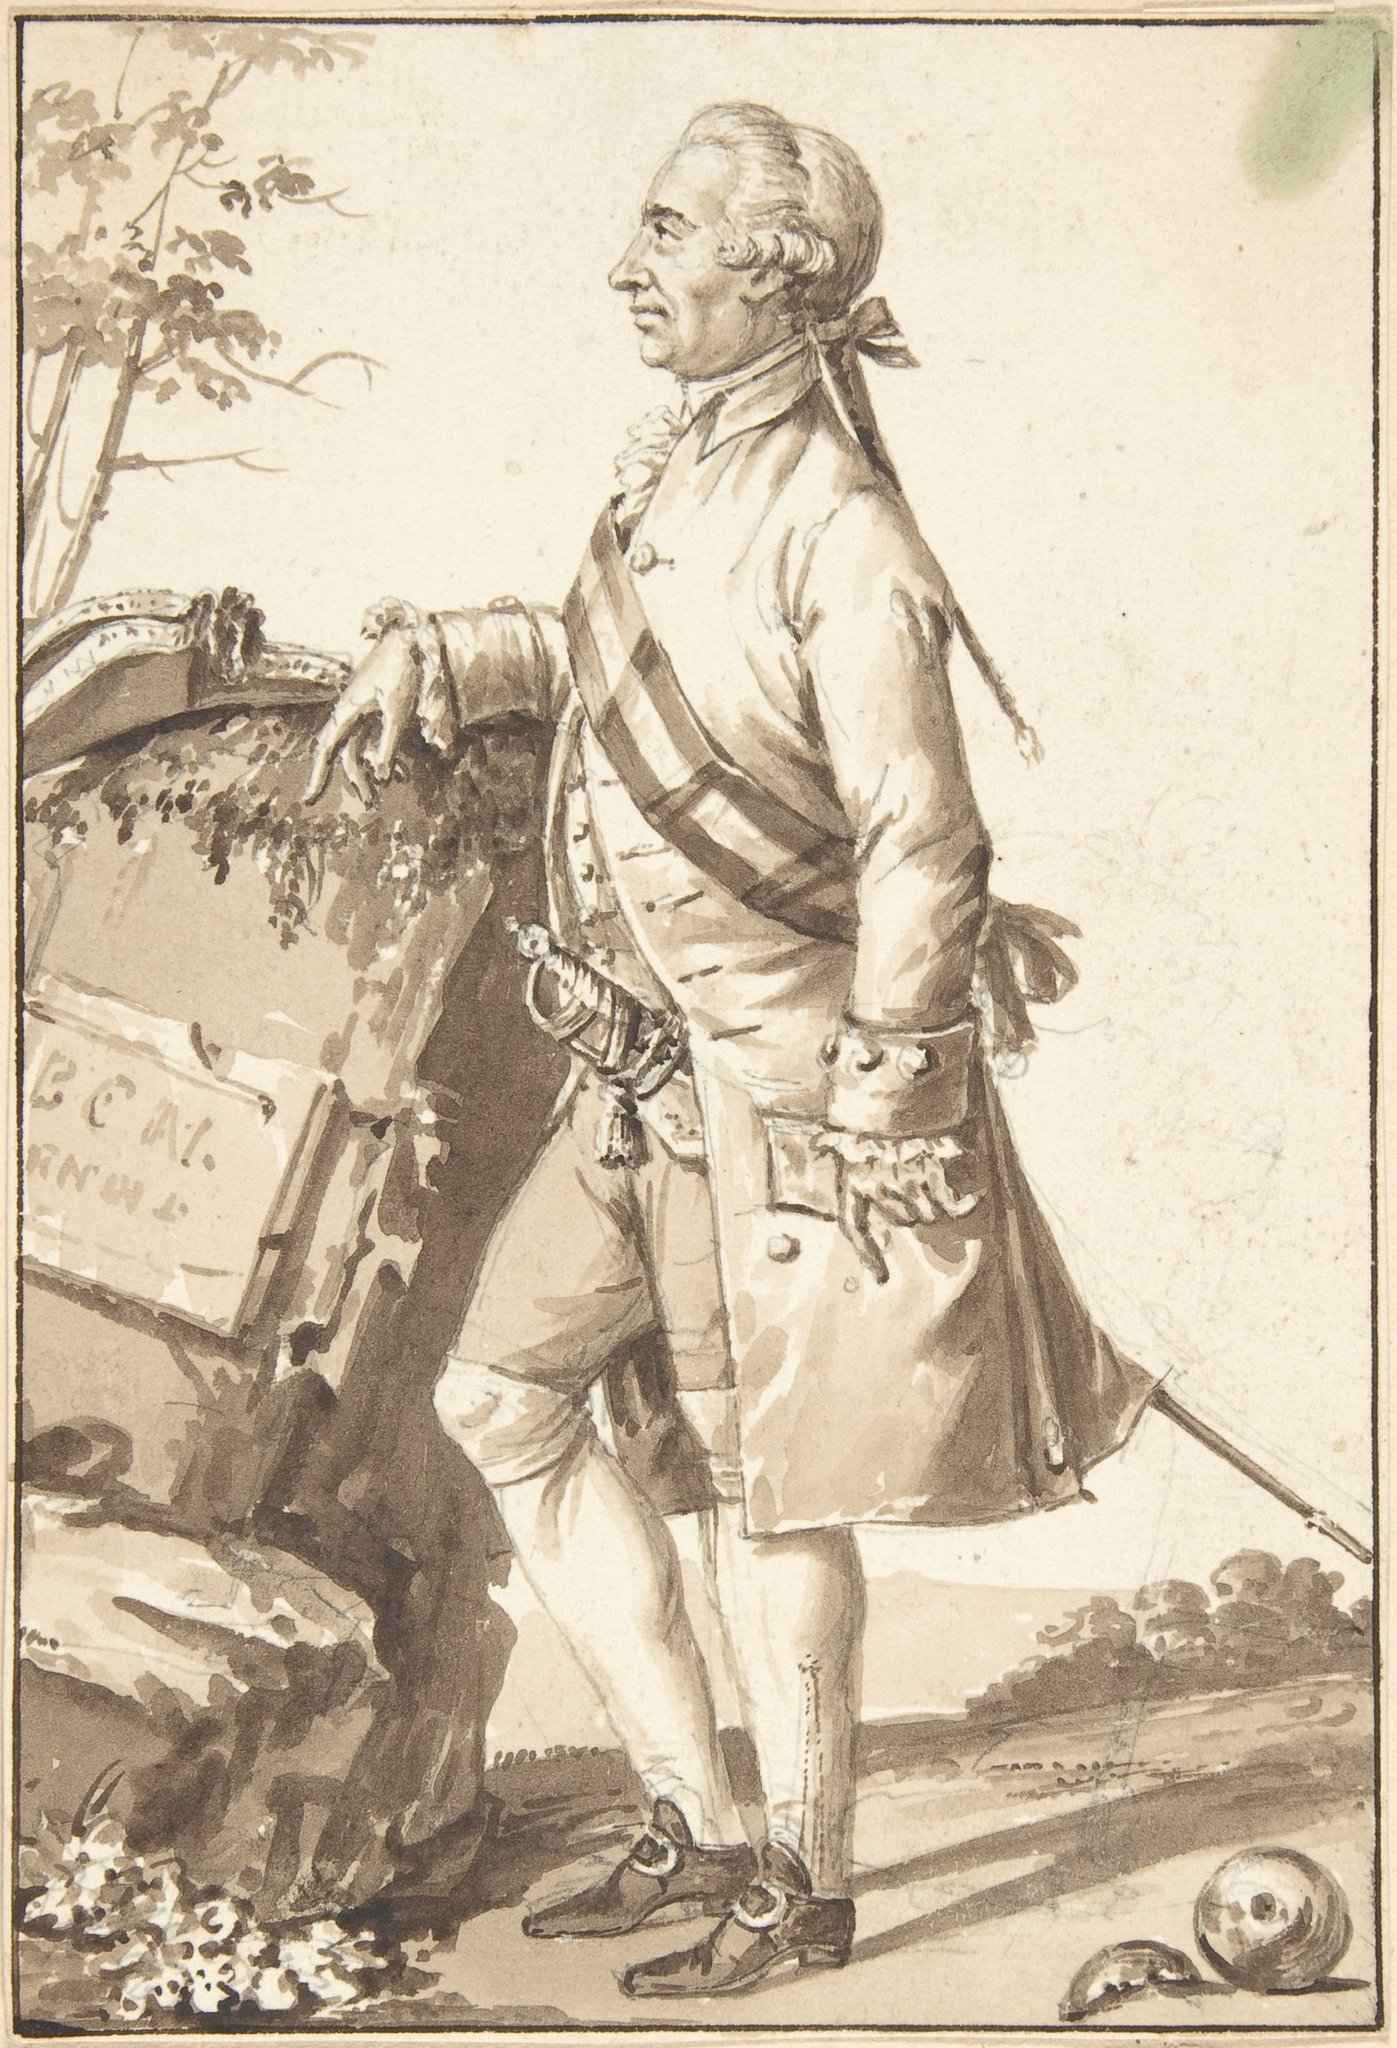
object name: drawing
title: Portrait of Karl Wilhelm Ferdinand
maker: jean-baptiste-françois bosio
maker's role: artist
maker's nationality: french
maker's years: 1764-1827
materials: graphite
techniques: brush, wash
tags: swords,men,portraits